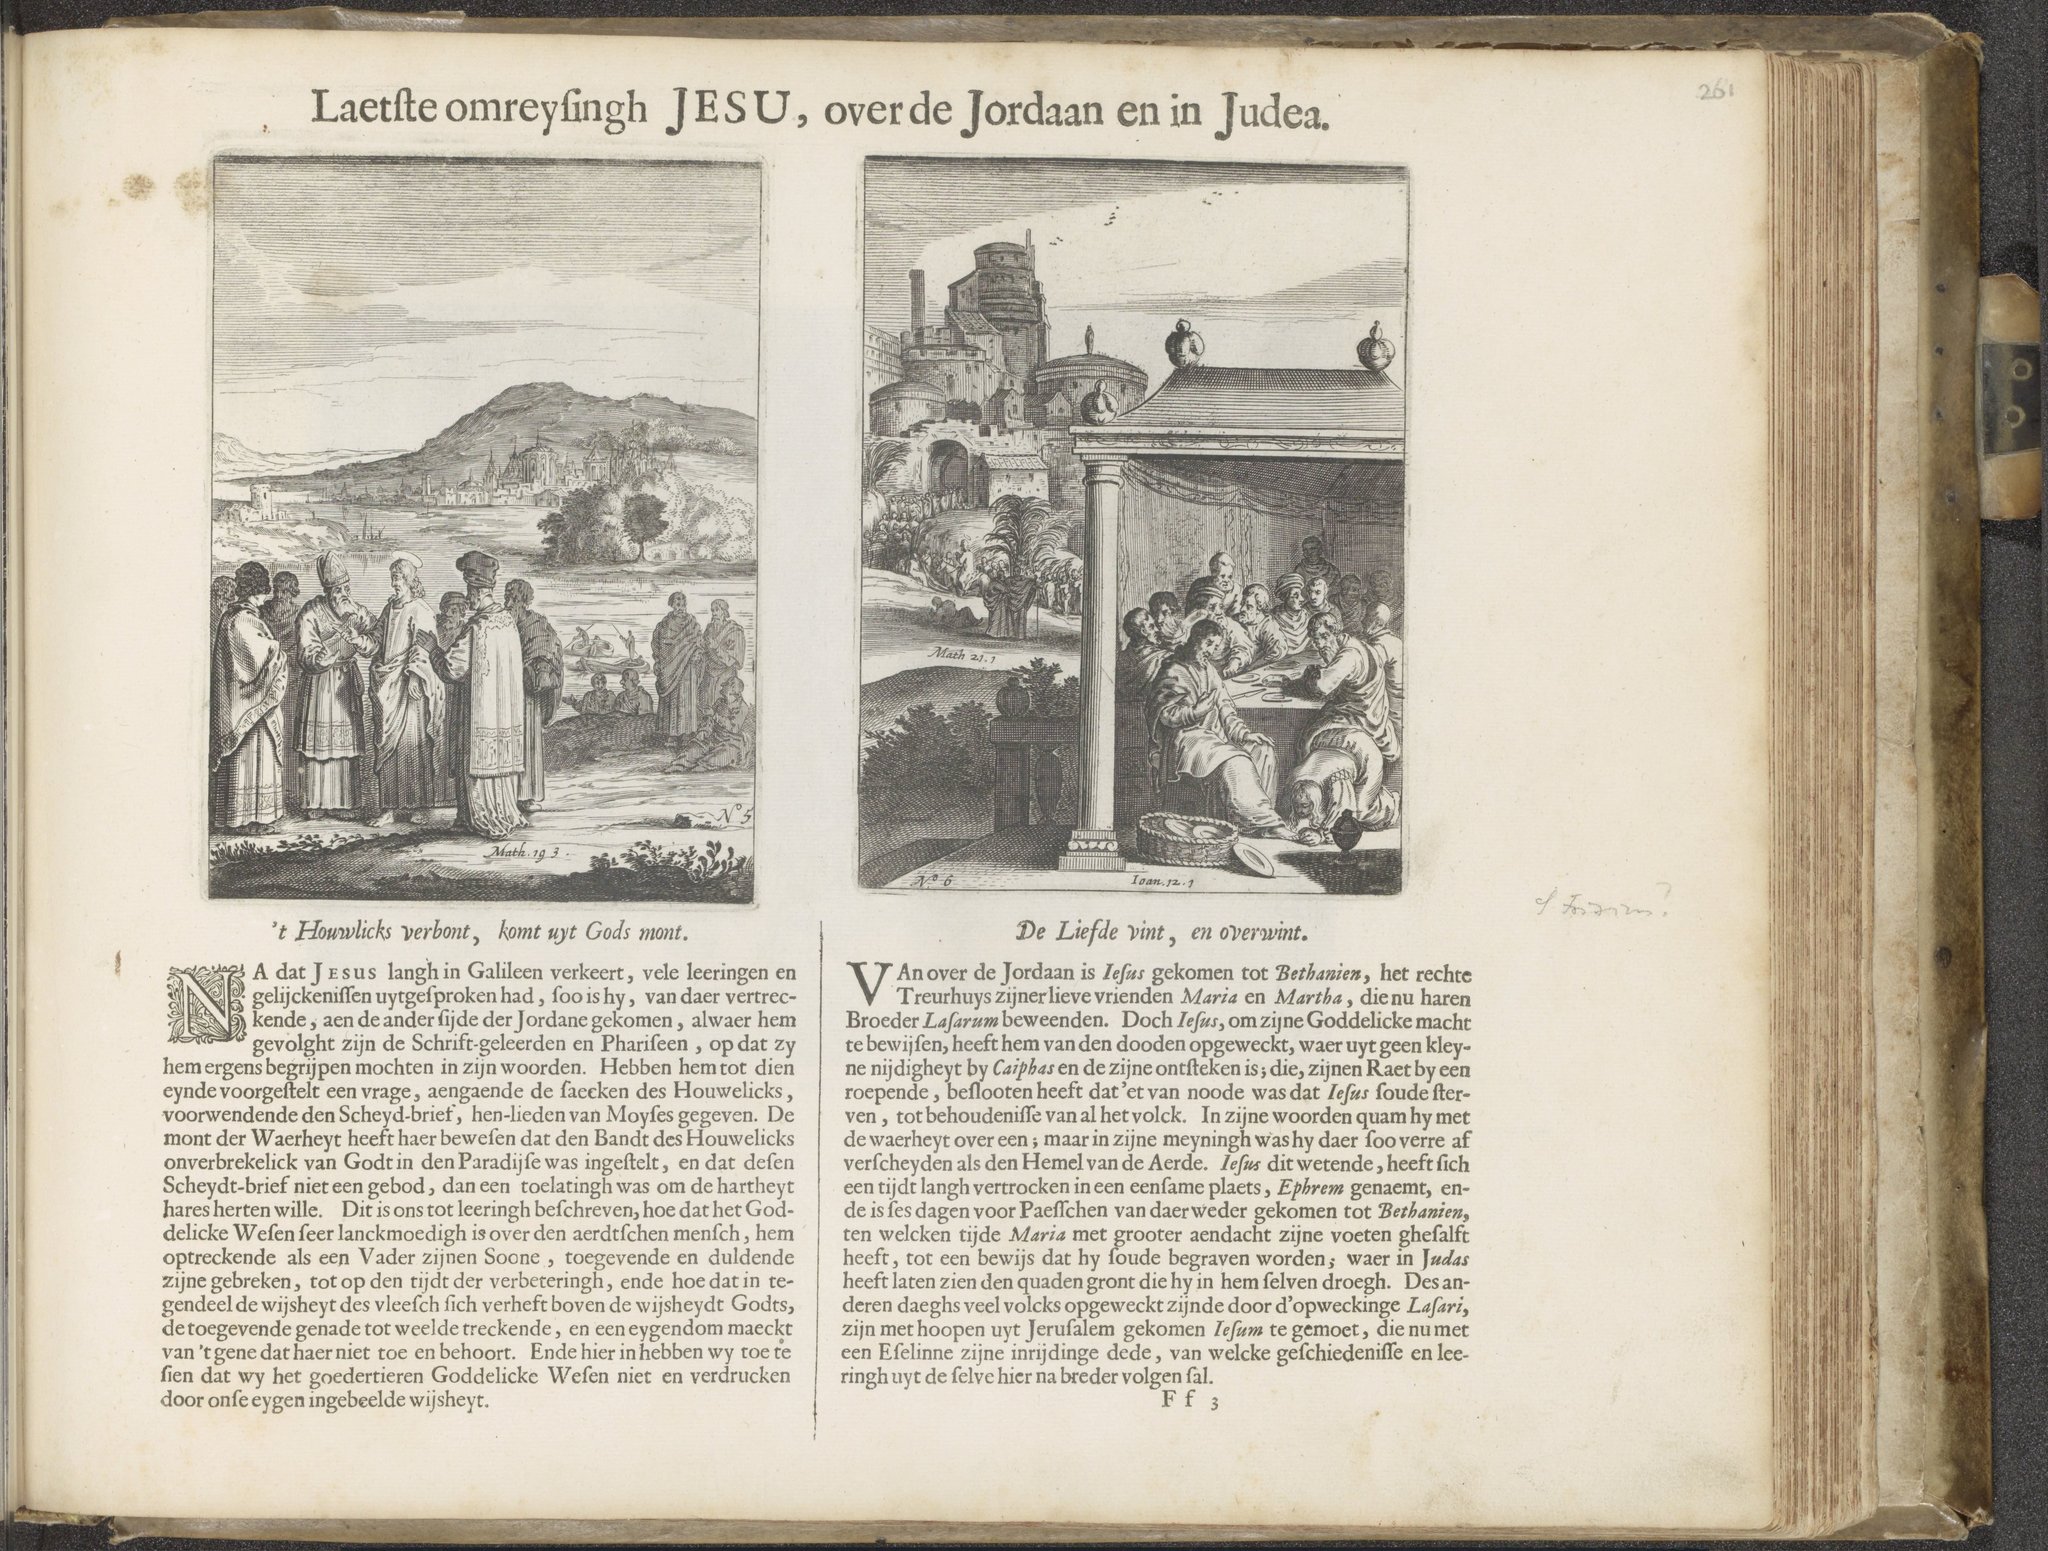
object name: print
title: Christus over het huwelijksverbond / Christus te gast bij Simon de Farizeeër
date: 1550-1650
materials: paper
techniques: engraving, etching, letterpress printing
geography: amsterdam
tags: a woman washes christ's feet with her tears, and wipes them with her hair, entry into jerusalem: people spreading their clothes before christ on the ass, and waving palm branches (matthew 21:1-11, 21:14-16; mark 11:1-11; luke 19:28-40; john 12:12-19)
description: Twee voorstellingen op een albumblad met toelichting. Links een voorstelling van Christus bij de Jordaan, in gesprek met enkele Farizeeën over het huwelijksverbond (Mat. 19:3). Rechts zit Christus aan tafel bij Simon de Farizeeër, terwijl Maria Magdalena zijn voeten zalft en met haar haar droogt (Joh. 12:1). Op de achtergrond de intocht in Jeruzalem (Mat. 21:1). De begeleidende tekst begint met een kleine gedecoreerde initiaal N. Het blad maakt deel uit van een album.